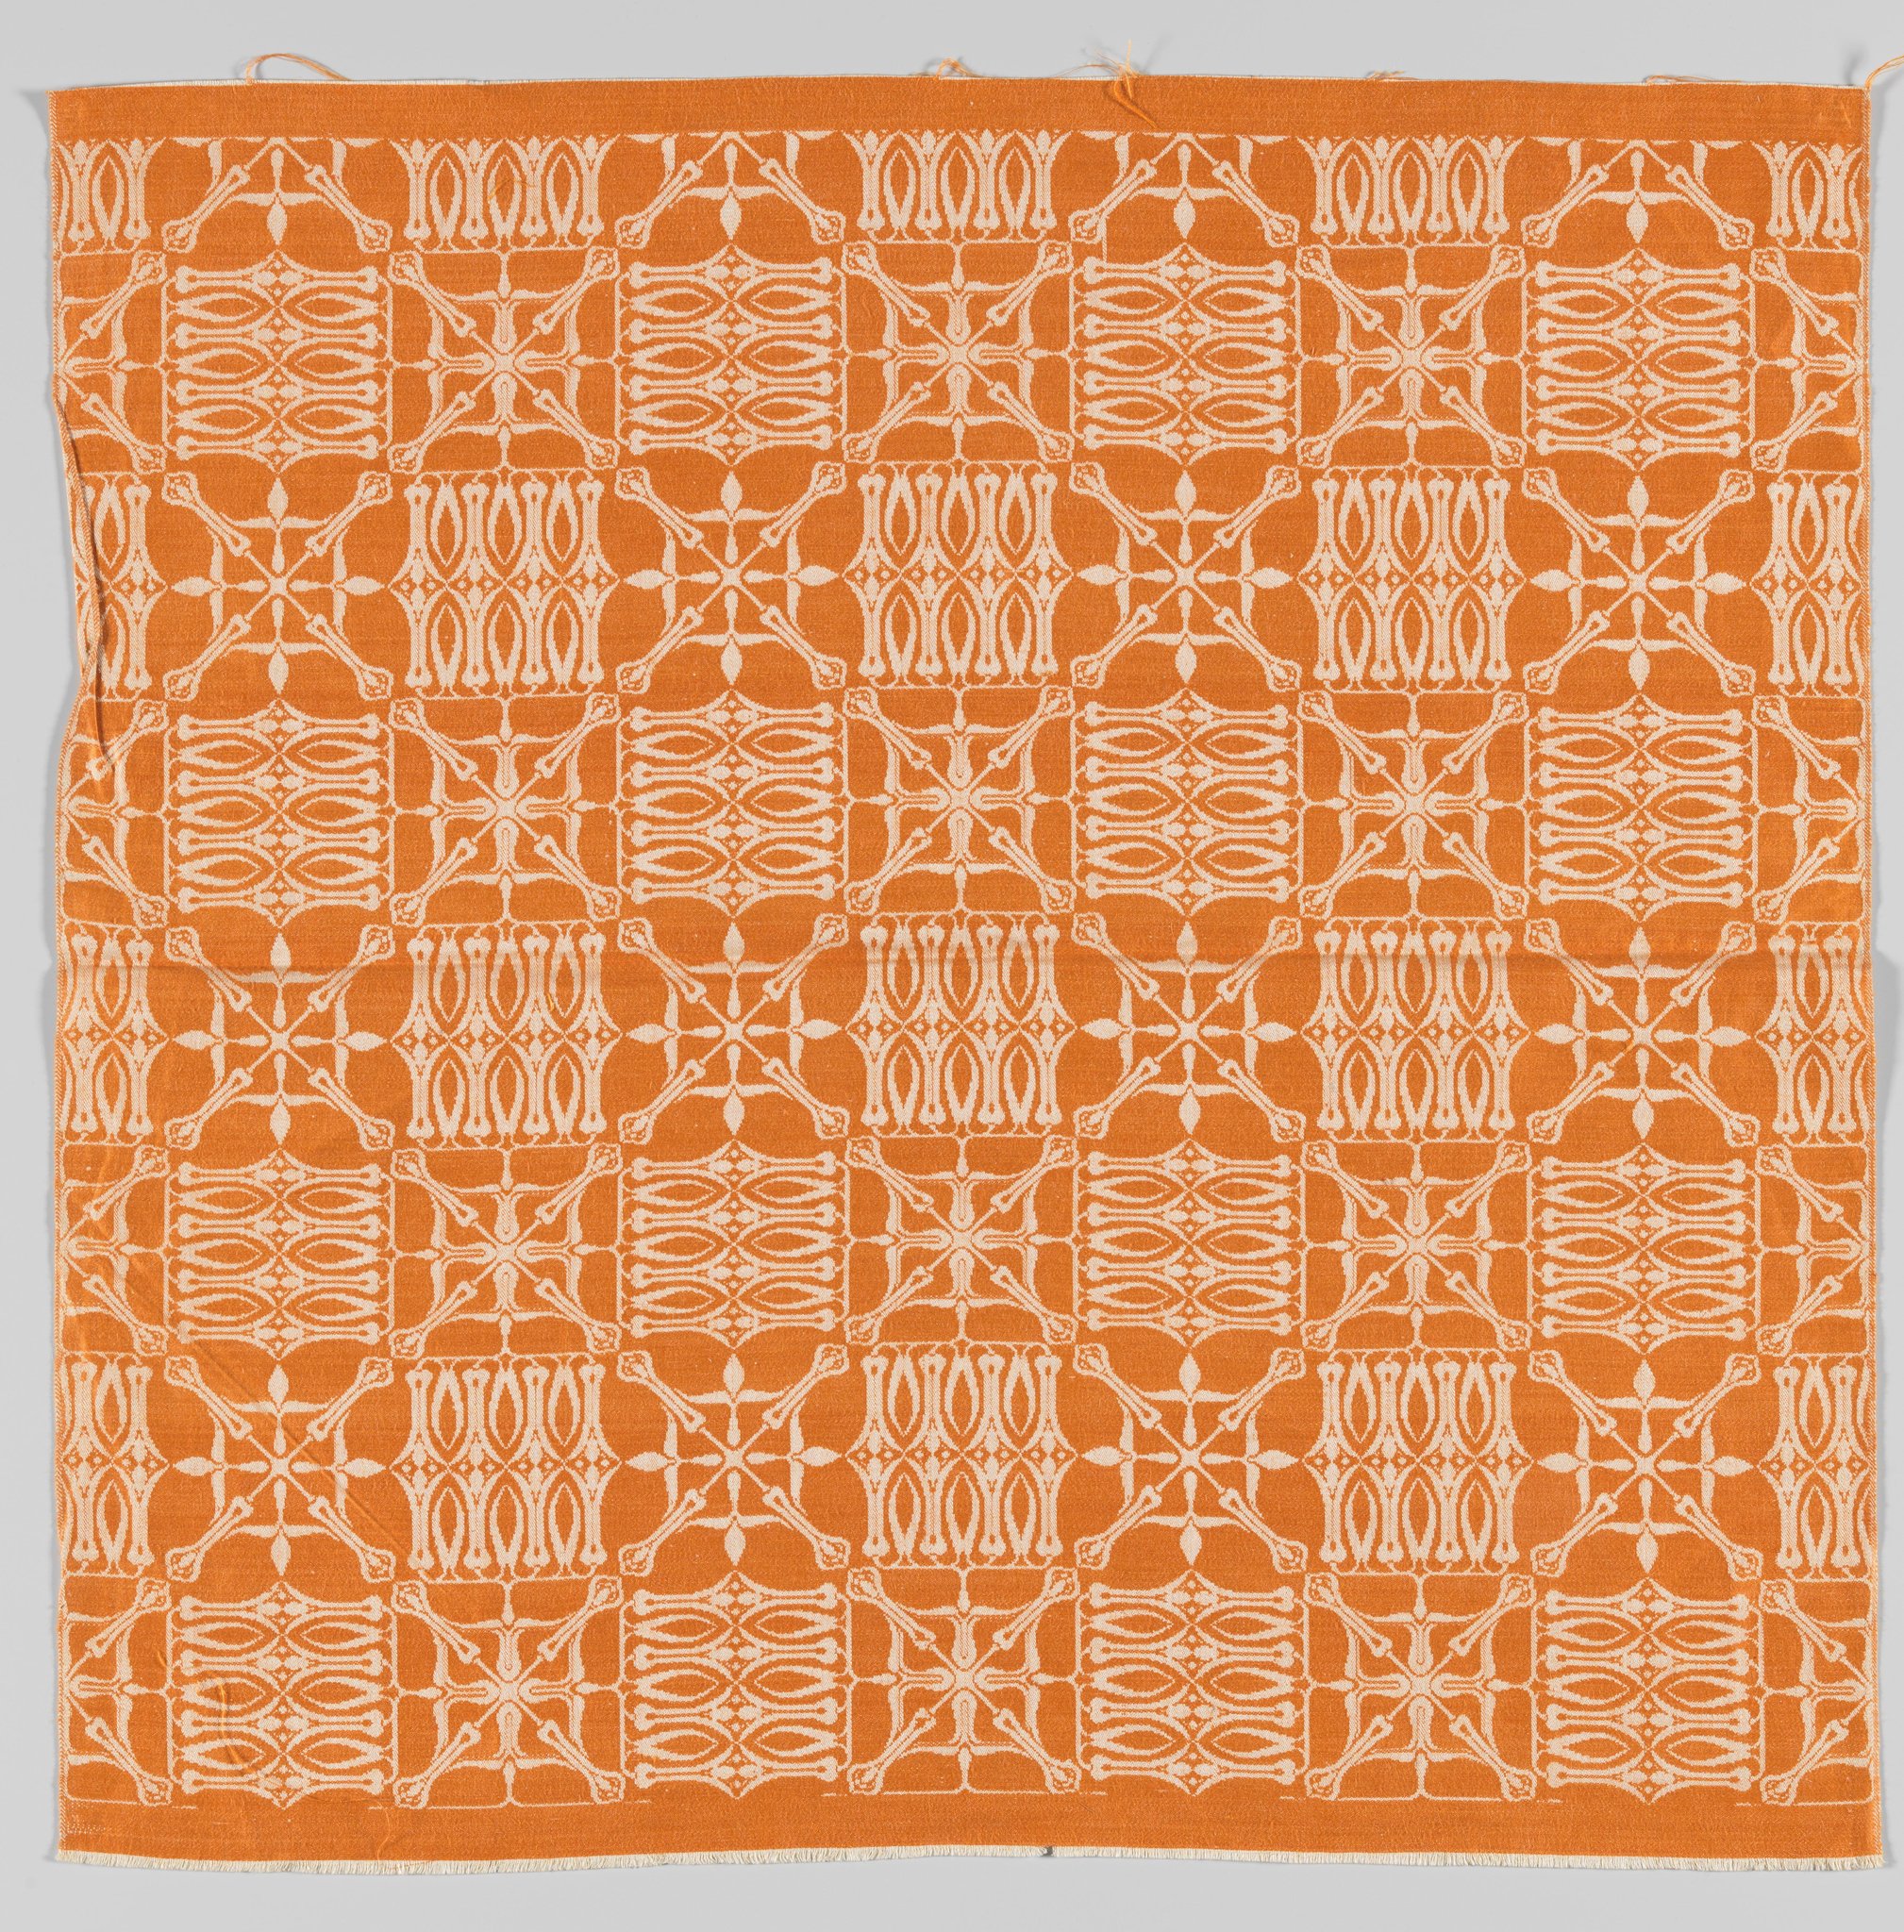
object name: upholstery fabric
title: Staal bespanningsstof van linnendamast met nagelbloemen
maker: chris lebeau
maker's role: draughtsman, print maker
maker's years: 1878-1945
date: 1911-1915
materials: linen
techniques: damask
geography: eindhoven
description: Staal bespanningsstof van linnendamast met een gestileerd patroon van nagelbloemen in wit op een oranje grond.